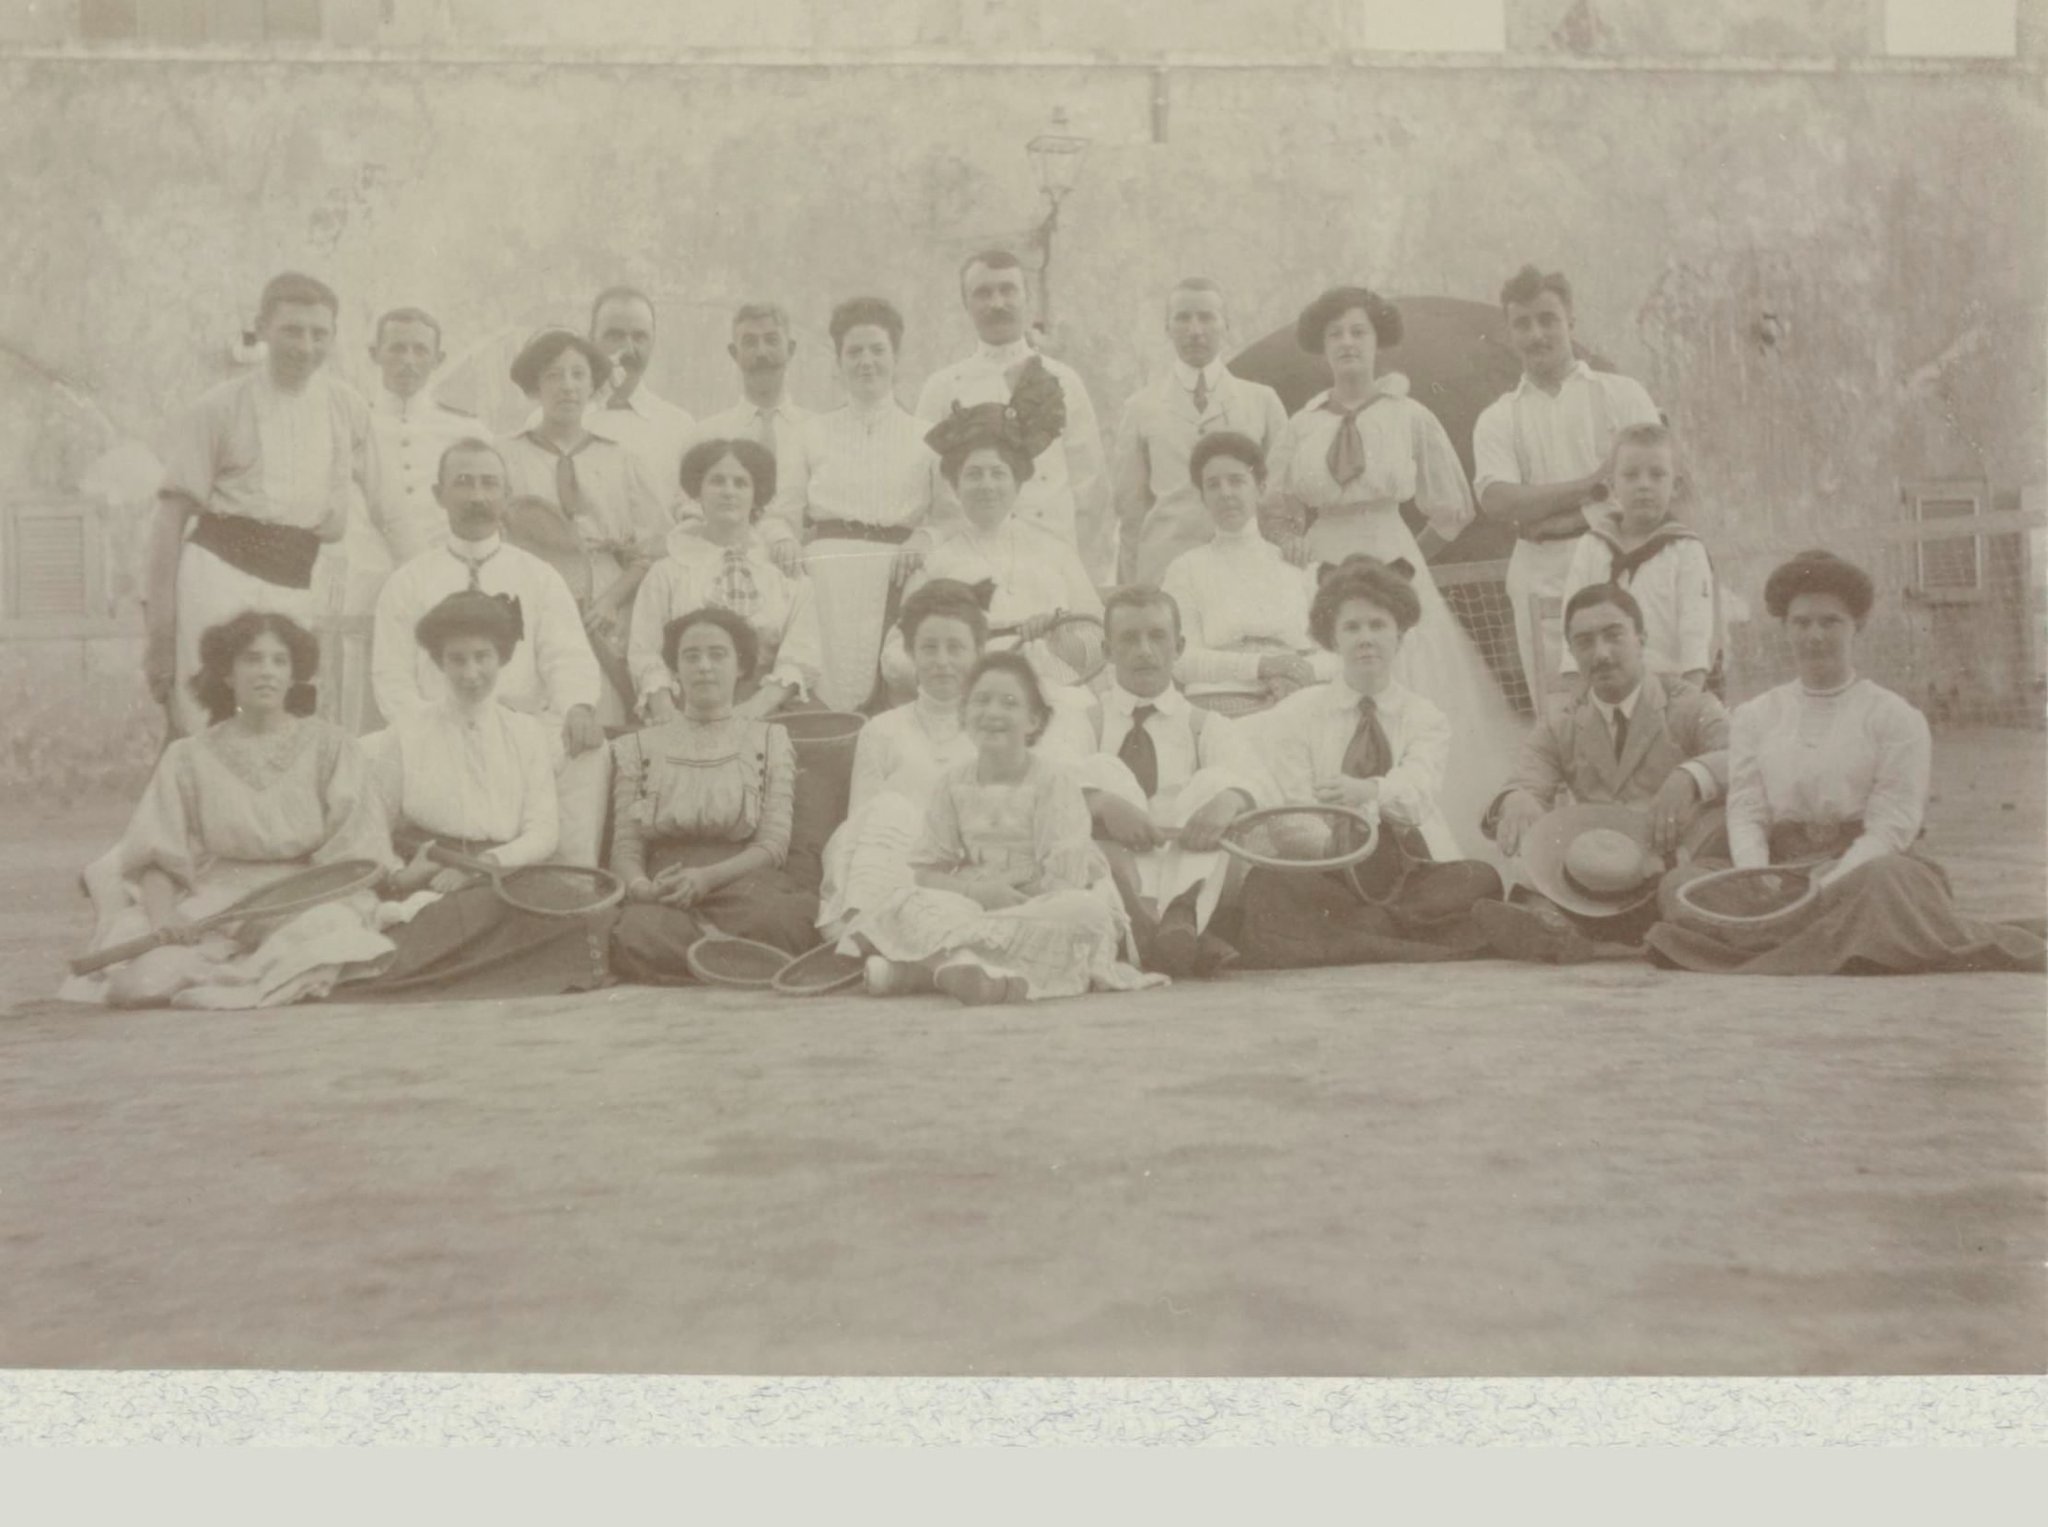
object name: photograph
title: Tennisclub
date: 1910-1911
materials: photographic support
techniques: photography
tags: andries augustus boom, tennis, lawn-tennis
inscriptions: inscription: ‘adelb. 1ste kl. Bloem ... Mej. Willemse’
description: Groepsfoto van de leden van een tennisclub, waarschijnlijk op Curaçao. Derde van rechts op de achterste rij is Andries Boom. Naast de foto de namen van de meeste van de personen. De mannen in het opschrift aangeduid met hun rang in de marine. Ca. 1910-1911. Onderdeel van het fotoalbum van de familie Boom-Gonggrijp in Suriname en Curaçao.